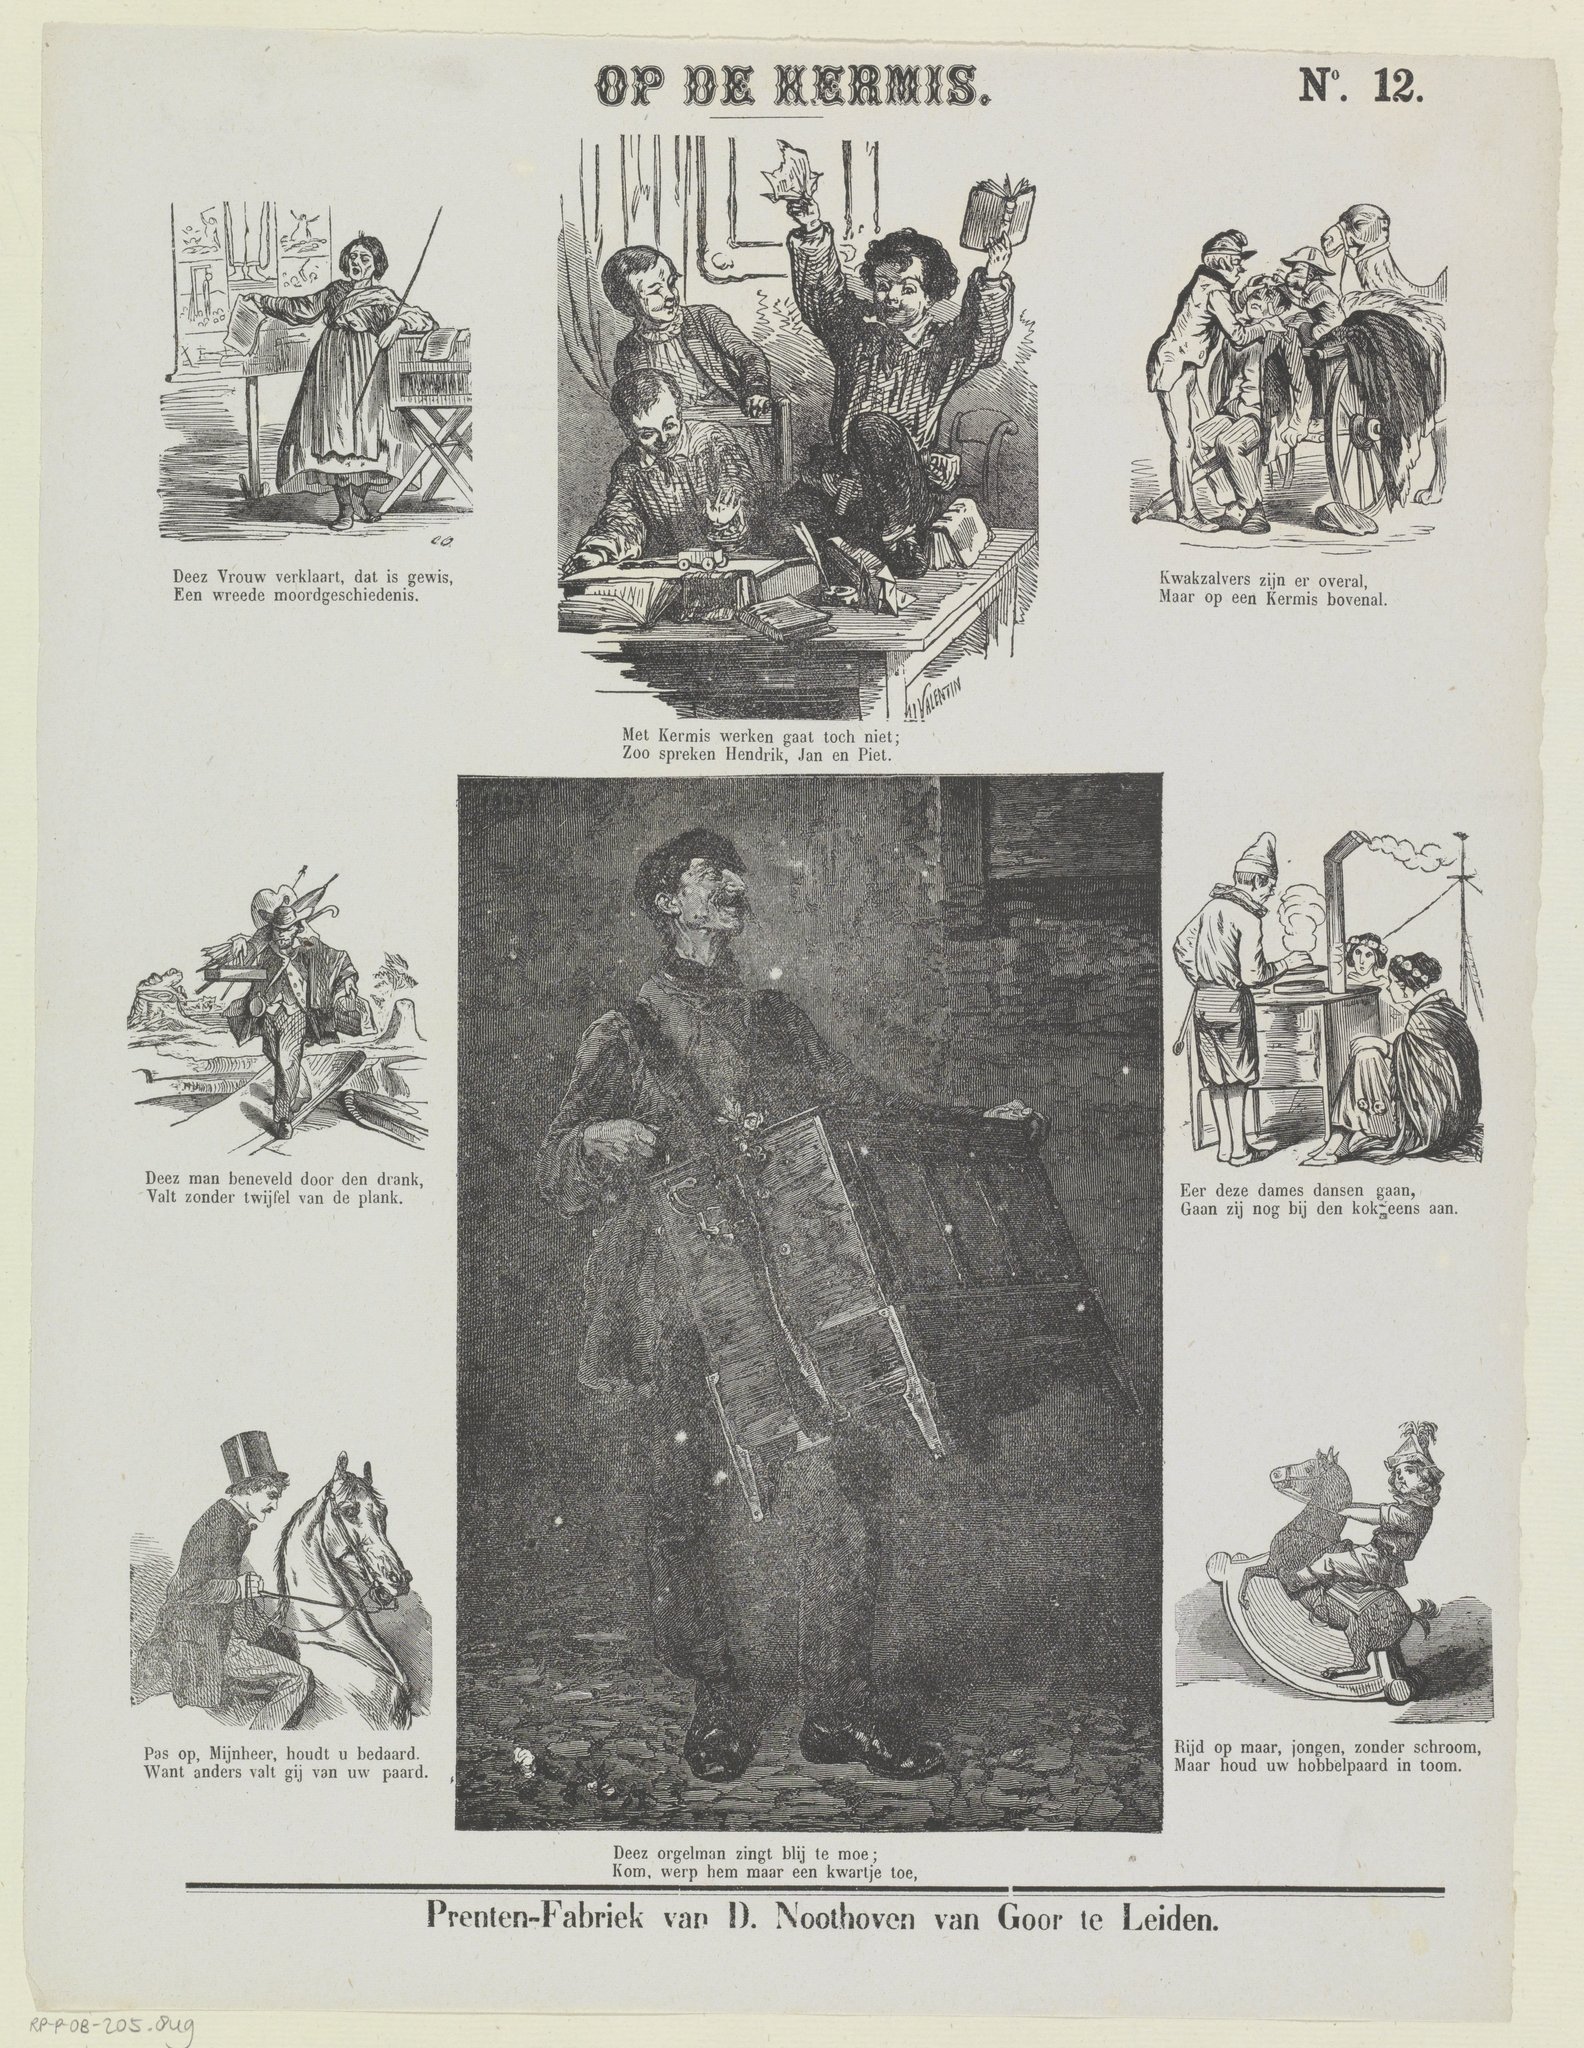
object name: print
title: Op de kermis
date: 1850-1881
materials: paper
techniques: letterpress printing, engraving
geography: leiden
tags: musician at work - cc - out of doors, human types, quack, charlatan, mountebank, 'saltimbanco', teacher and pupil, rocking-horse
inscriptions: collector's mark: Lugt 2760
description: Blad met 8 voorstellingen van een lerares, schoolkinderen, een kwakzalver en andere figuren. Onder elke voorstelling een tweeregelig vers. Genummerd rechtsboven: No. 12.